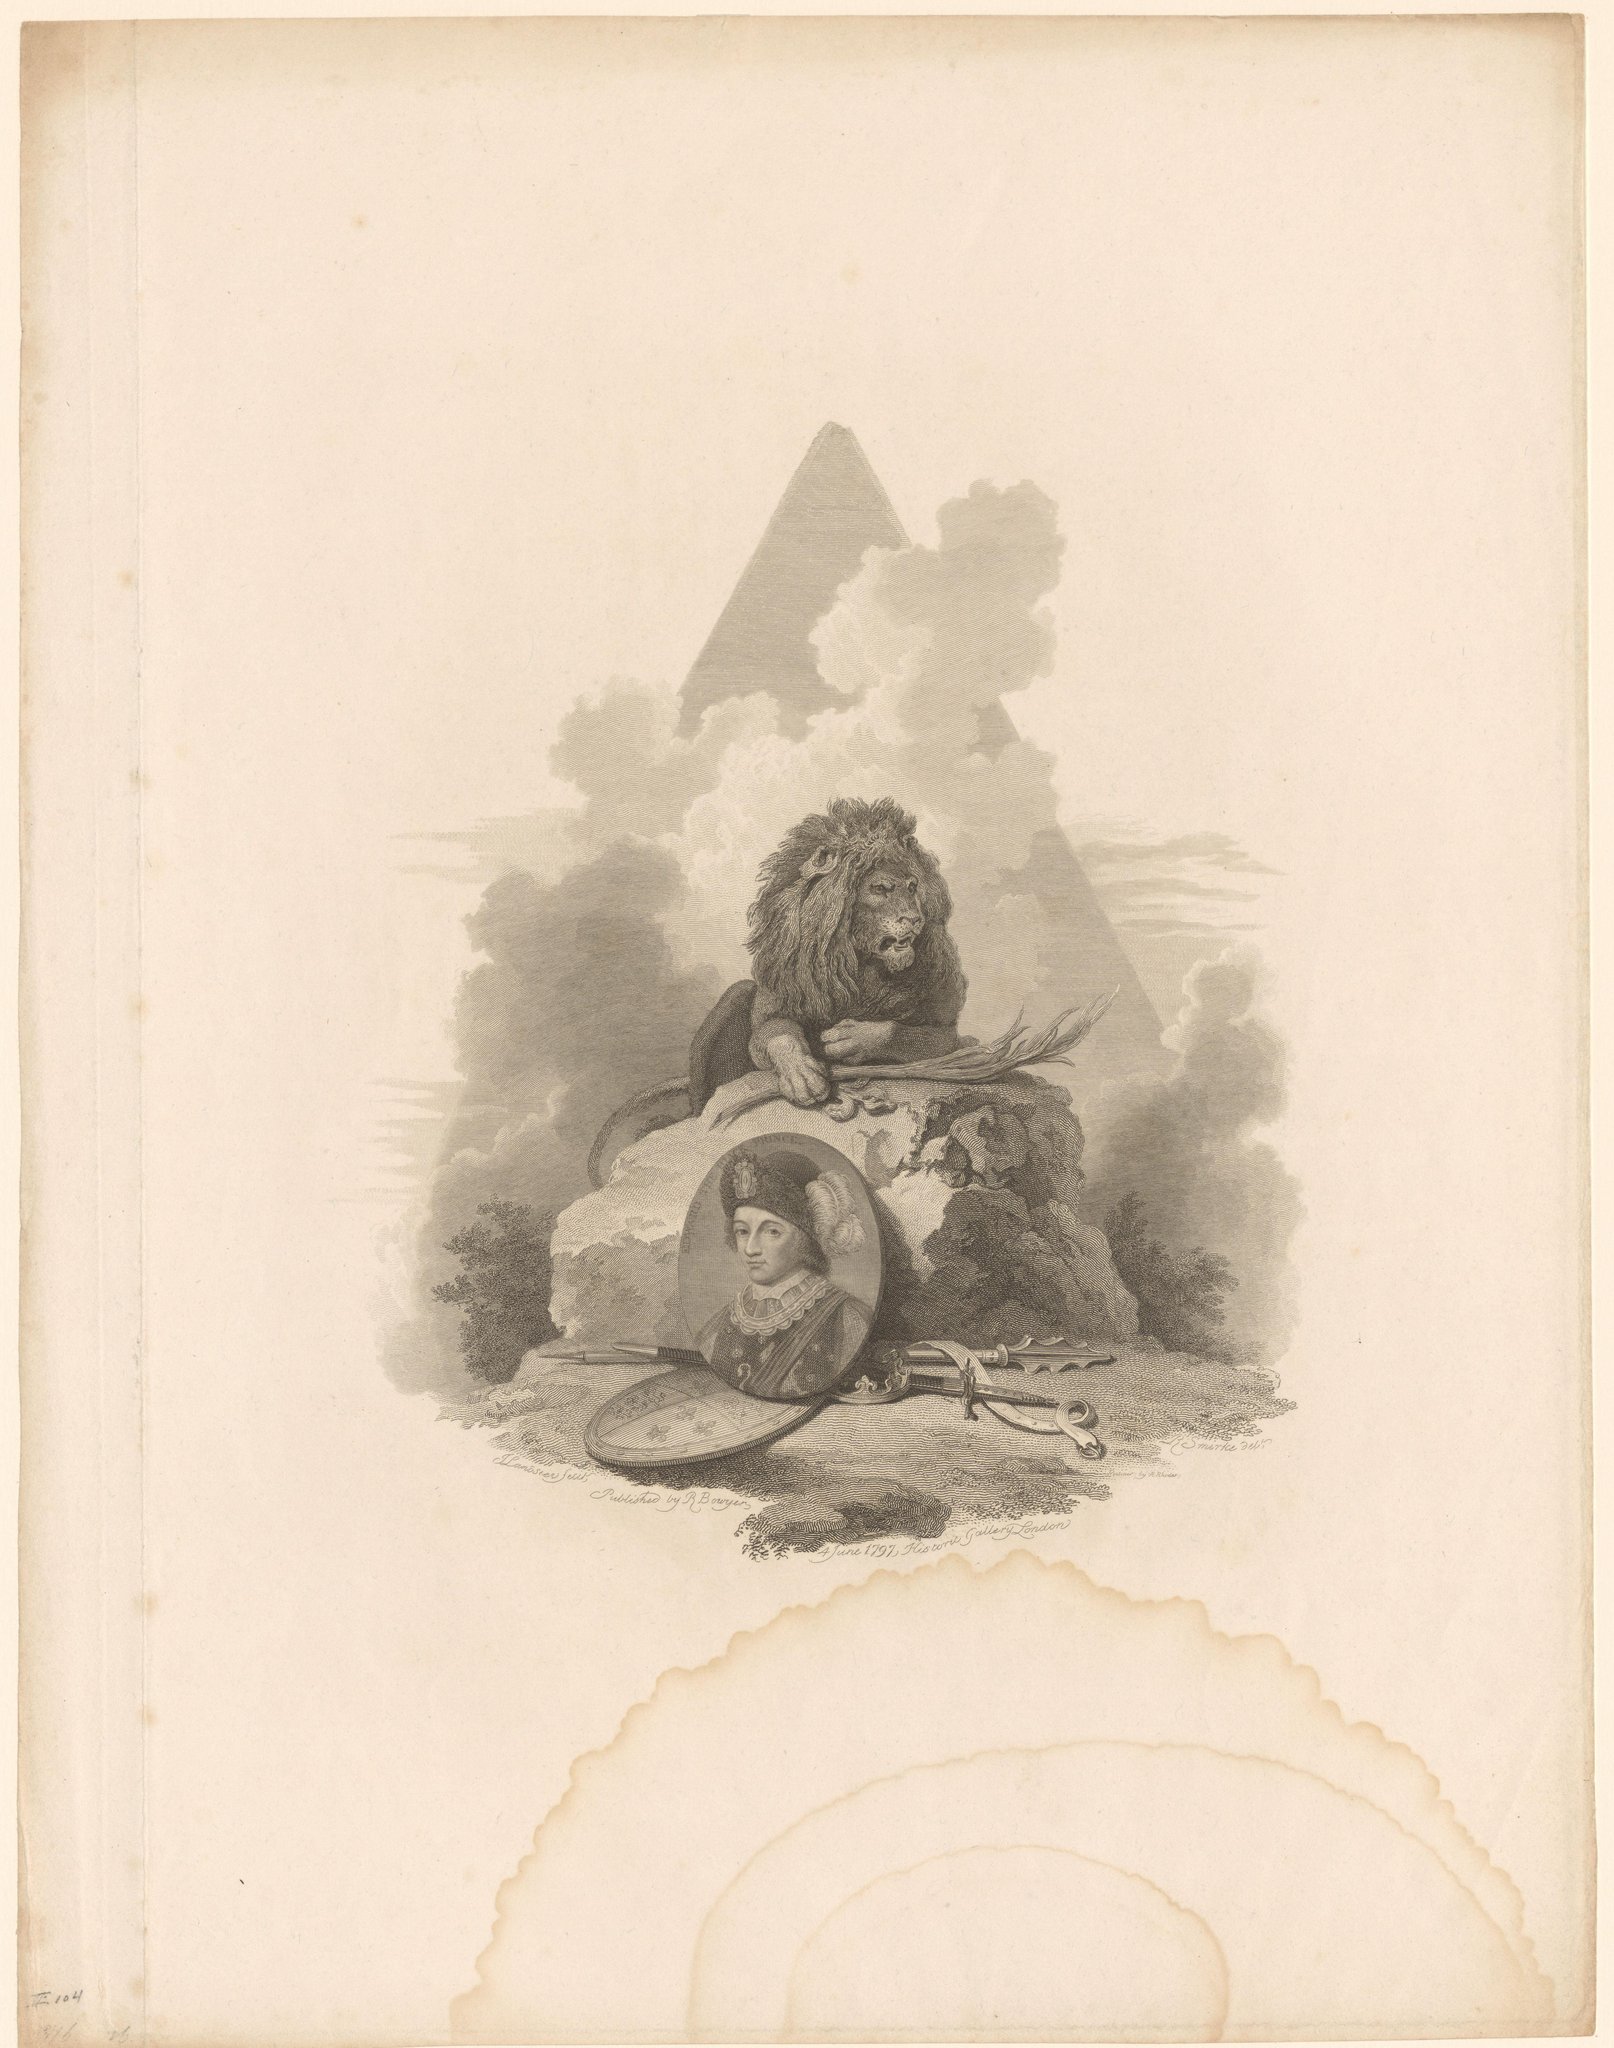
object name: print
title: Portret van Eduard van Woodstock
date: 1797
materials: paper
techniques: etching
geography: london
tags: historical persons, officer, beasts of prey, predatory animals: lion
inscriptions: collector's mark: Lugt 2228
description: Onder het portretmedaillon wapens en een schild. Achter het medaillon een leeuw met palmtak op een rots en een piramide.